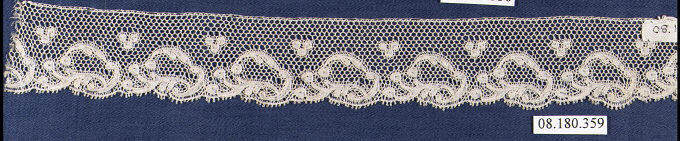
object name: fragment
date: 1801-1900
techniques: lace